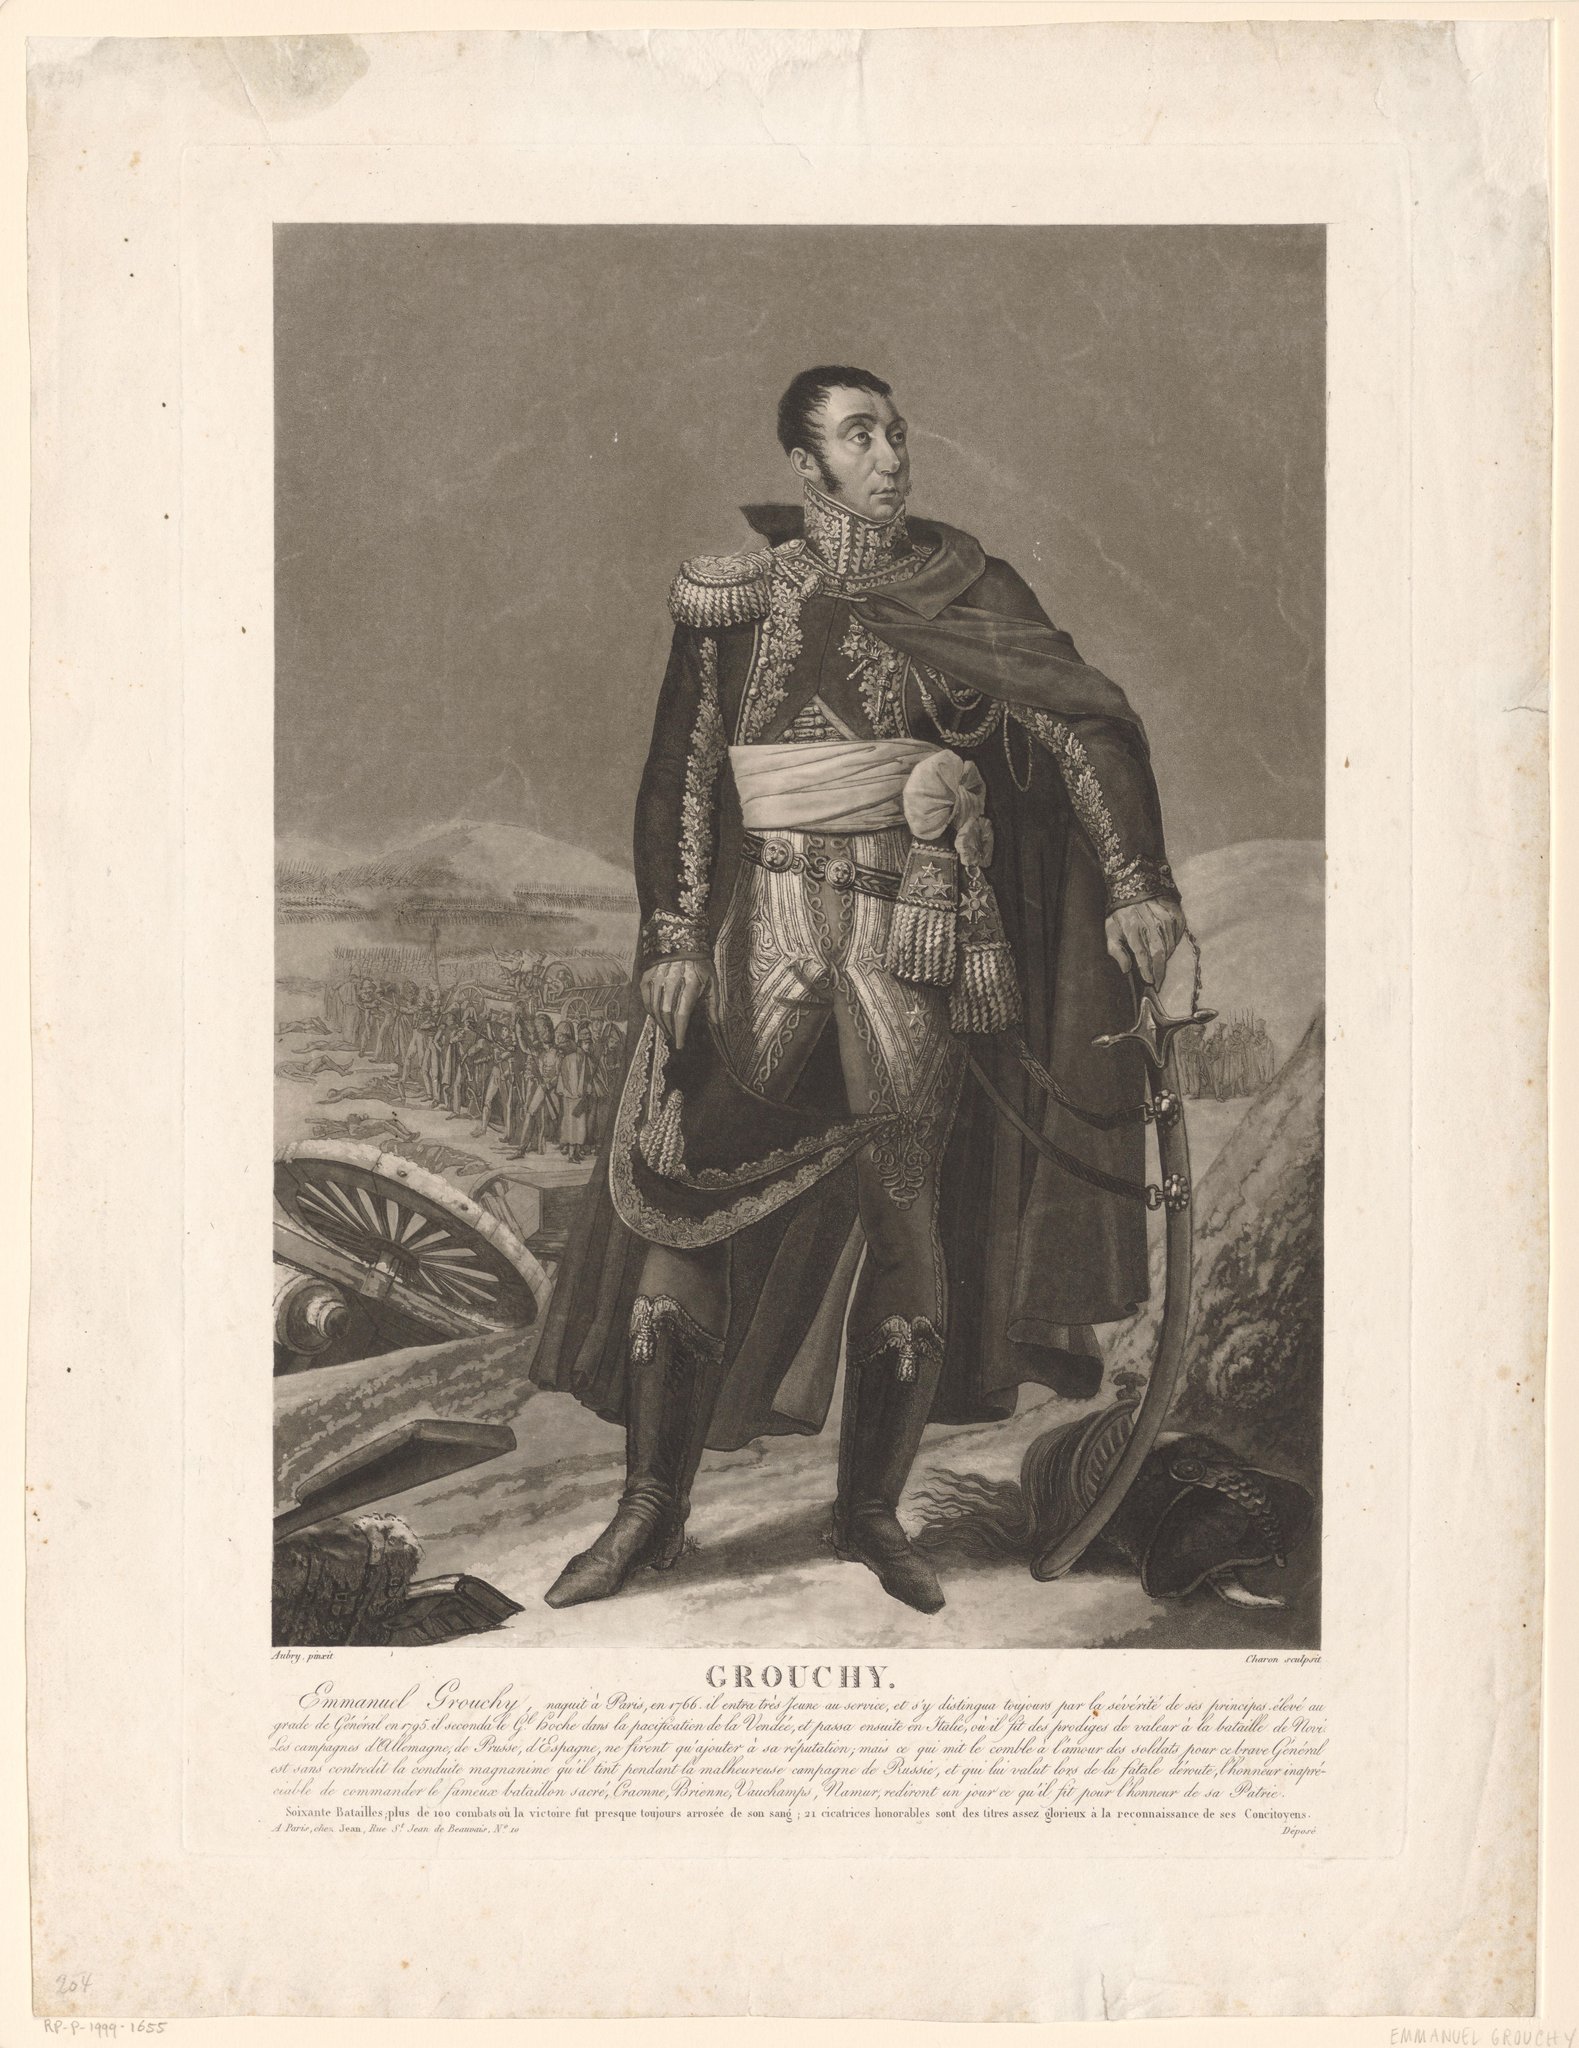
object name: print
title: Portret van Emmanuel Grouchy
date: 1800-1832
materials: paper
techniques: aquatint, engraving, etching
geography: paris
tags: paris, historical persons, battle, hacking and thrusting weapons: sword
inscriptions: collector's mark: Lugt 2228, collector's mark: Lugt 2760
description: Onder het portret een zesregelig onderschrift.